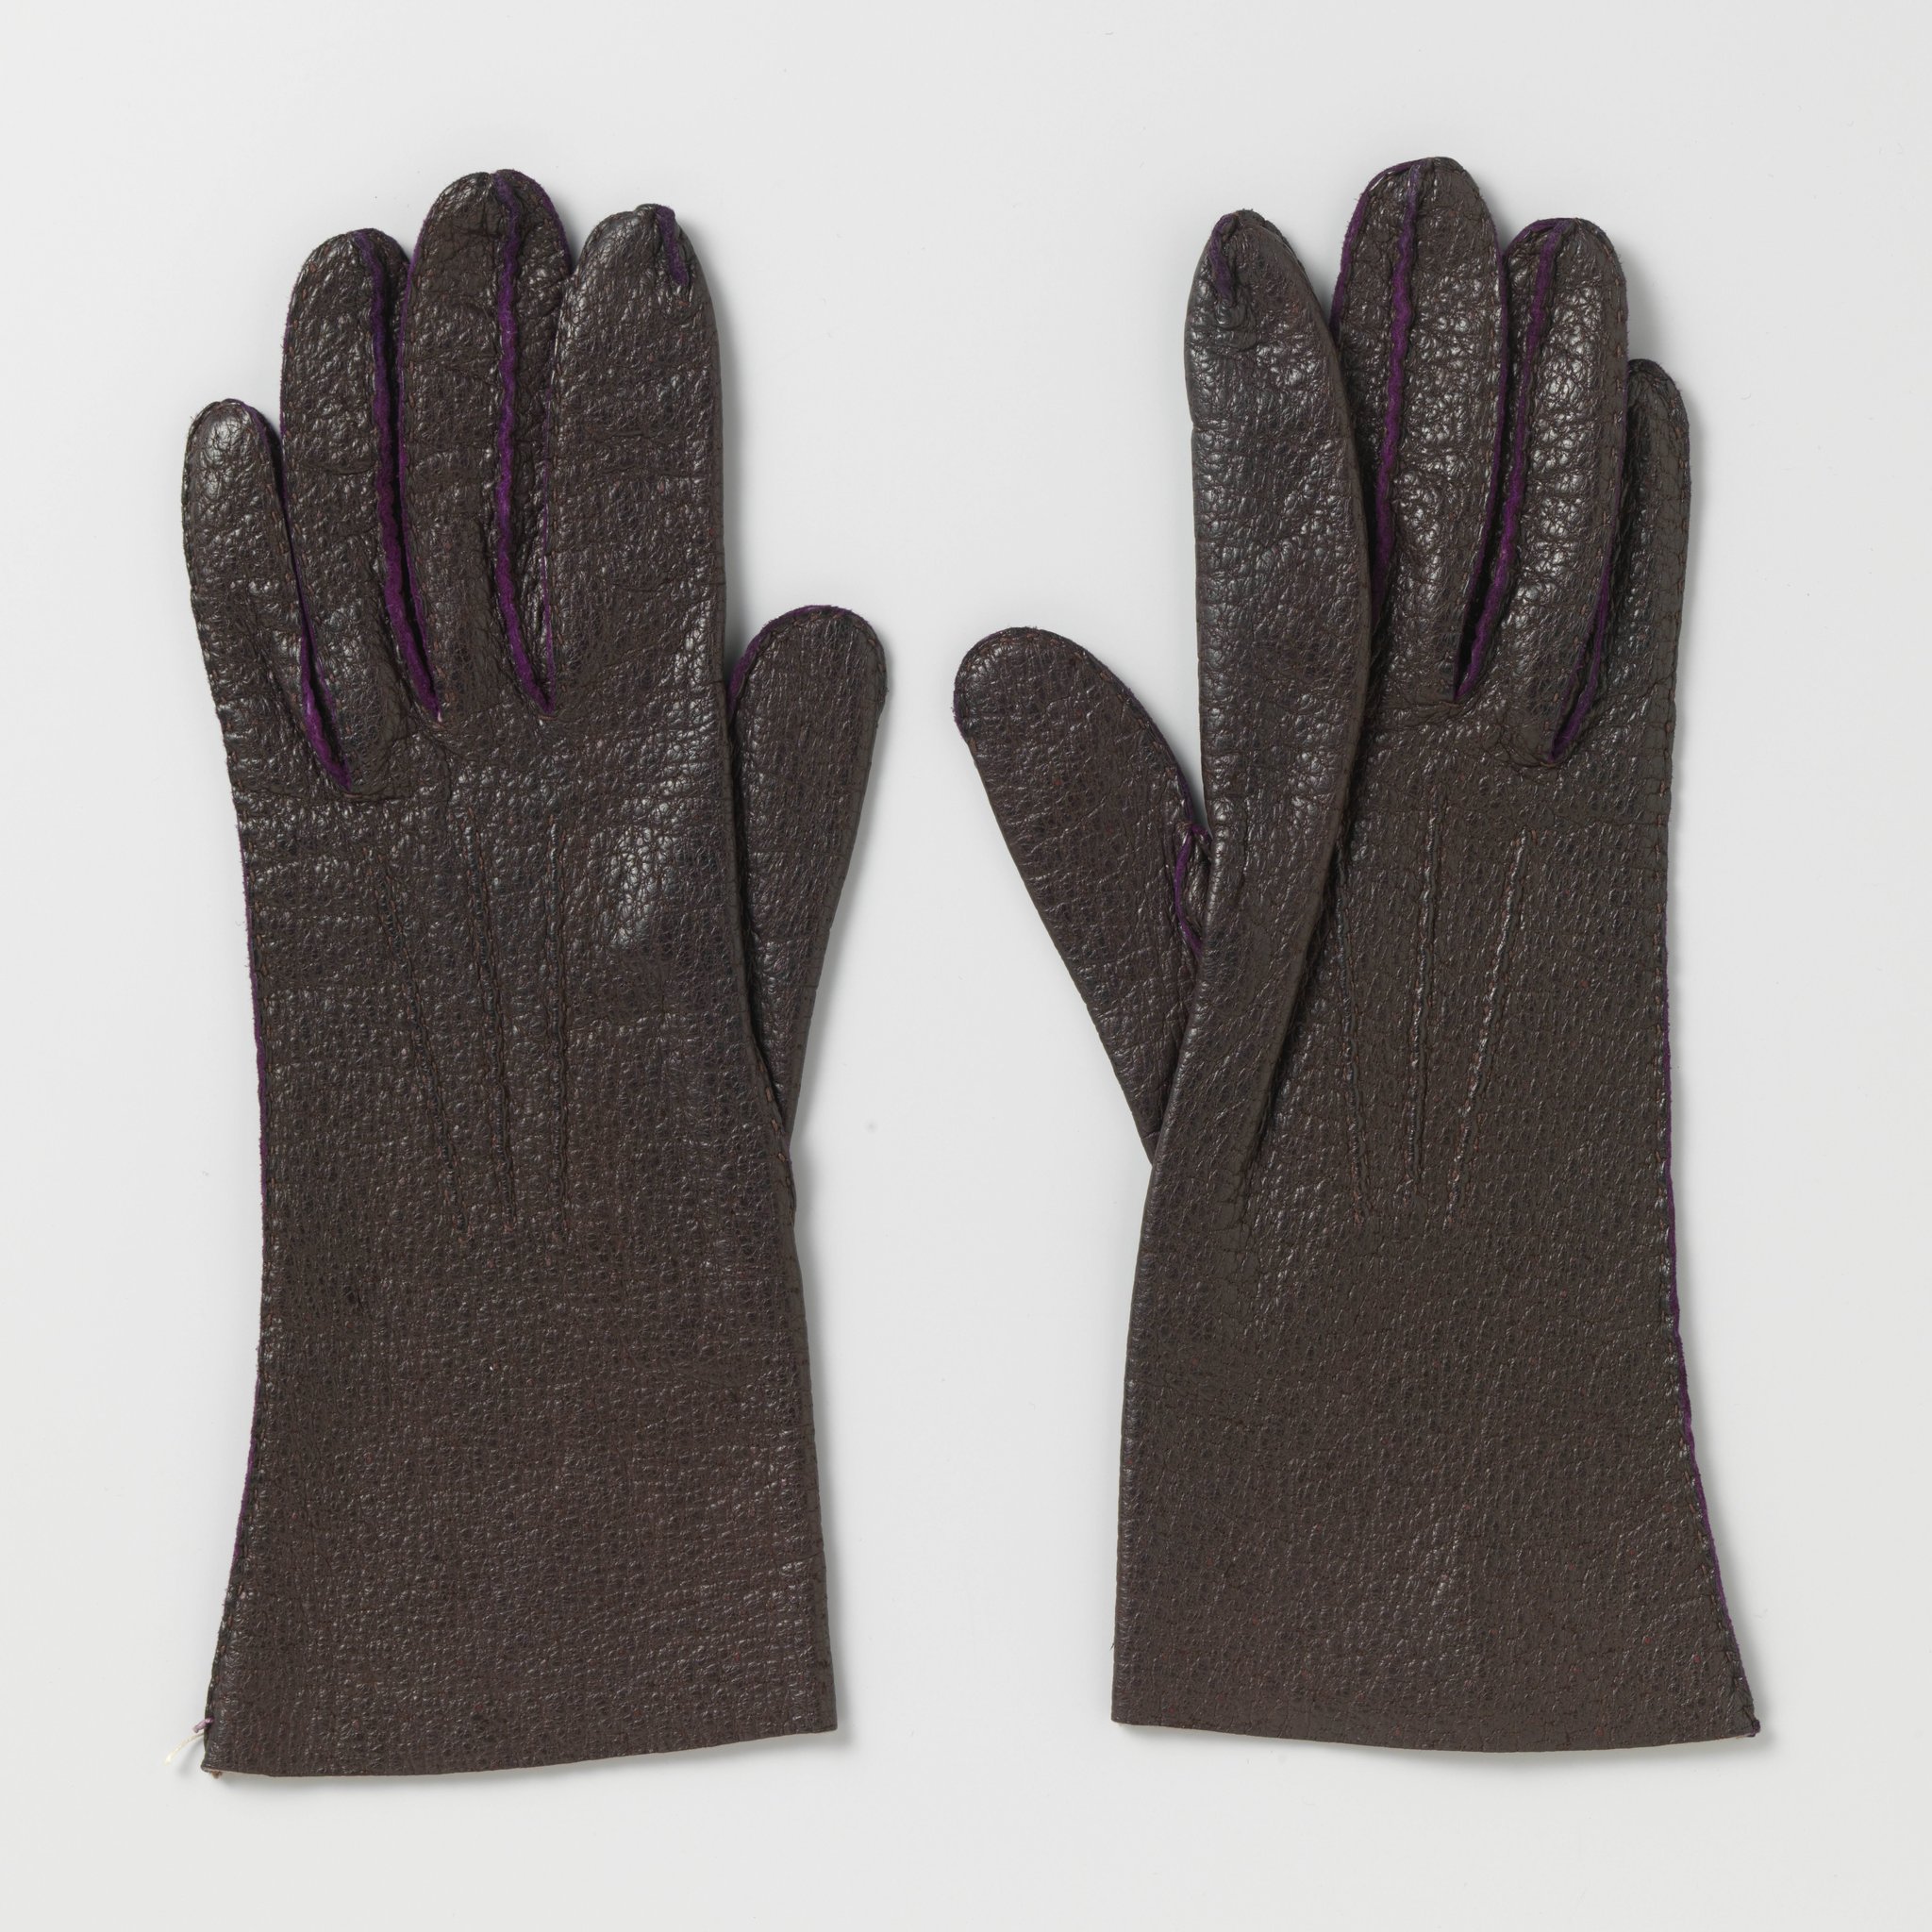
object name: glove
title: Pair of gloves with radiating cords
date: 1915-1950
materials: leather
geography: netherlands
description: Linker handschoen van donkerrood leer met op de rug drie uitstralende koorden.